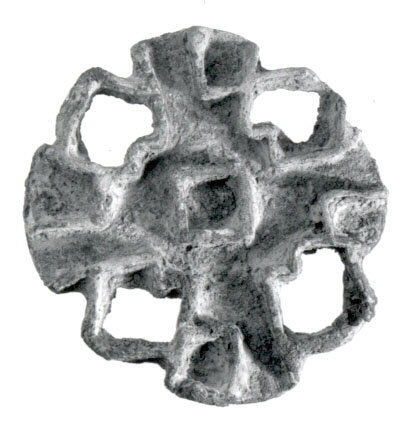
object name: stamp seal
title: Compartmented stamp seal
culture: bactria-margiana archaeological complex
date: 2333-1668 BCE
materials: copper alloy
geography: bactria-margiana